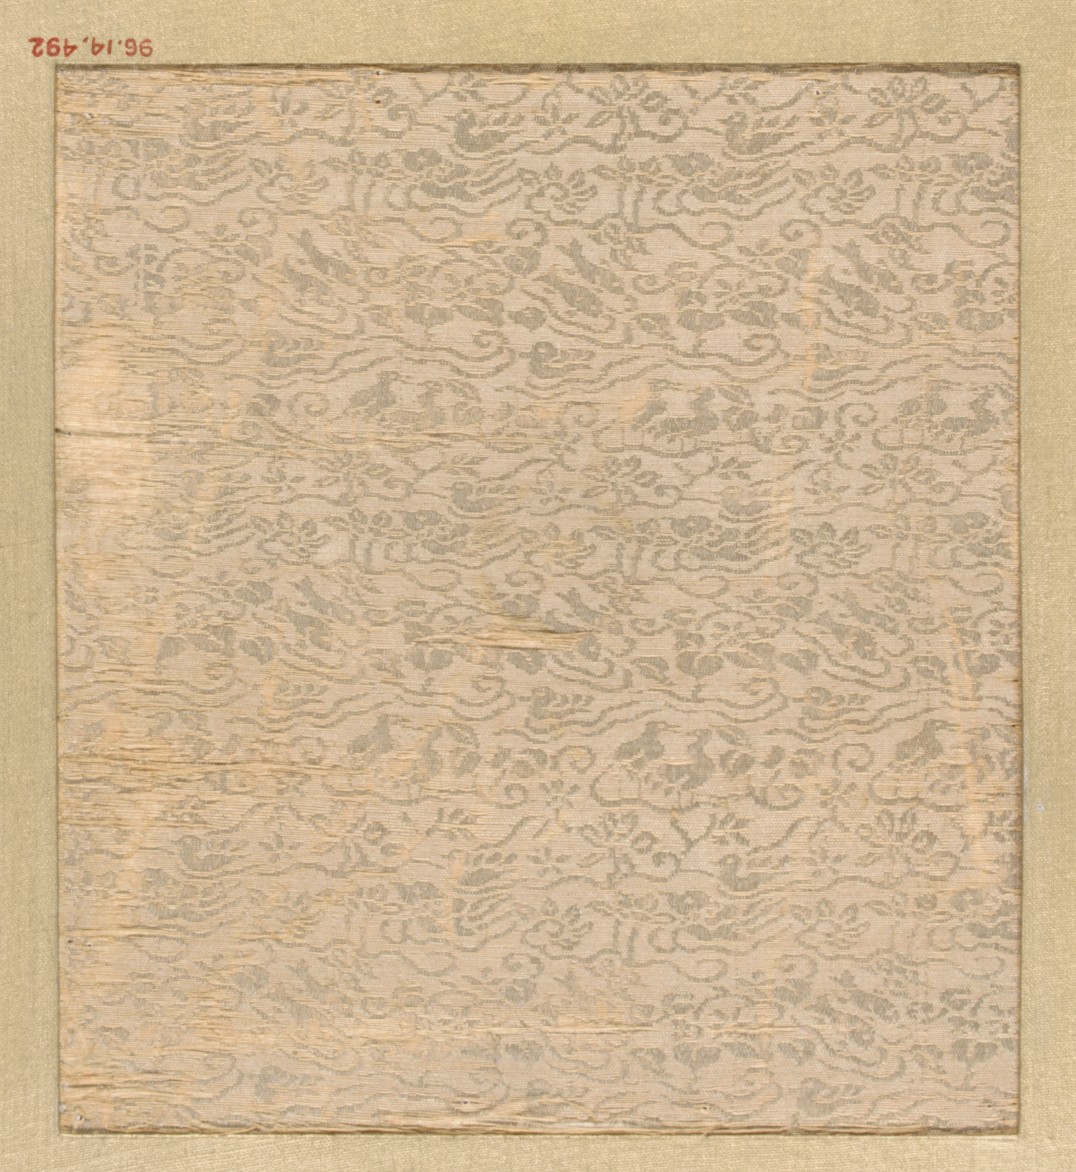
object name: piece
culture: japanese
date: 1701-1900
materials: silk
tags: fish